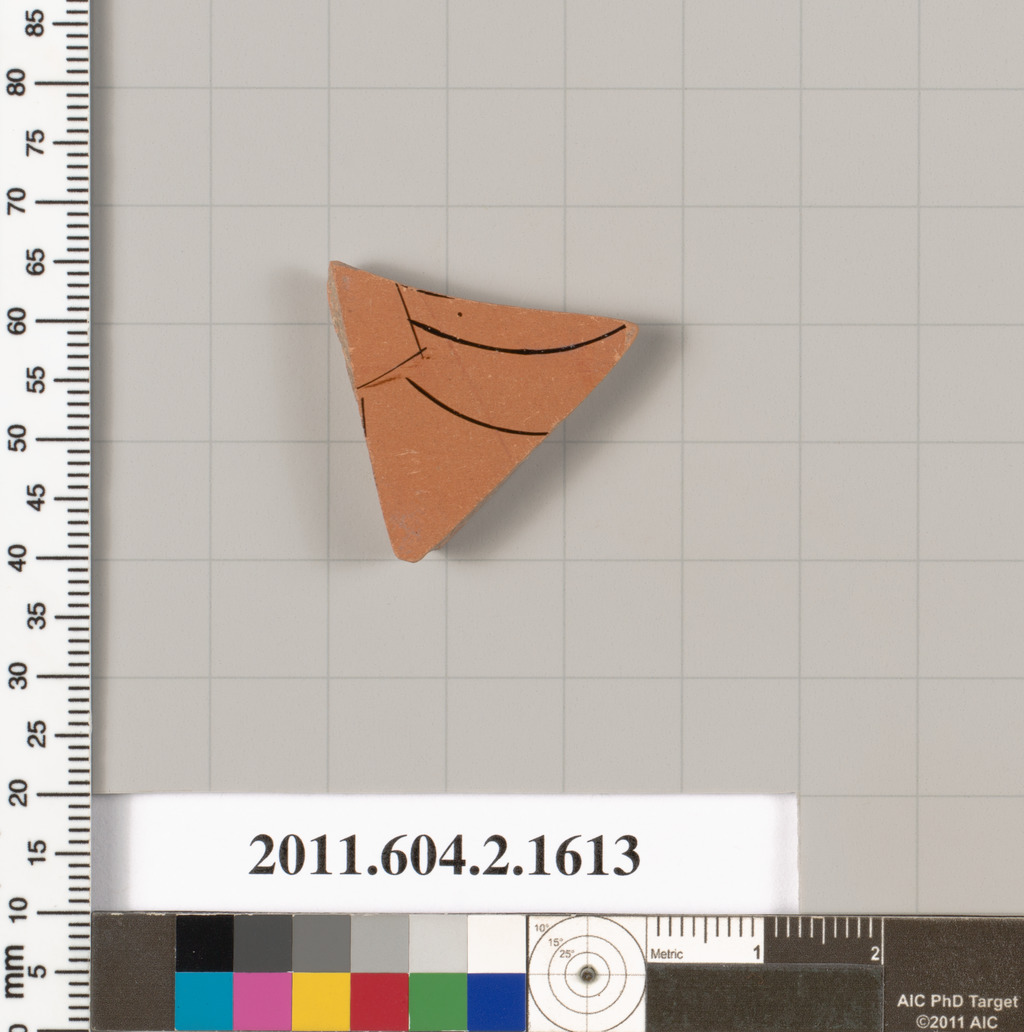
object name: skyphos fragment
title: Terracotta fragment of a skyphos (deep drinking cup)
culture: greek, attic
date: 460-440 BCE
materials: terracotta